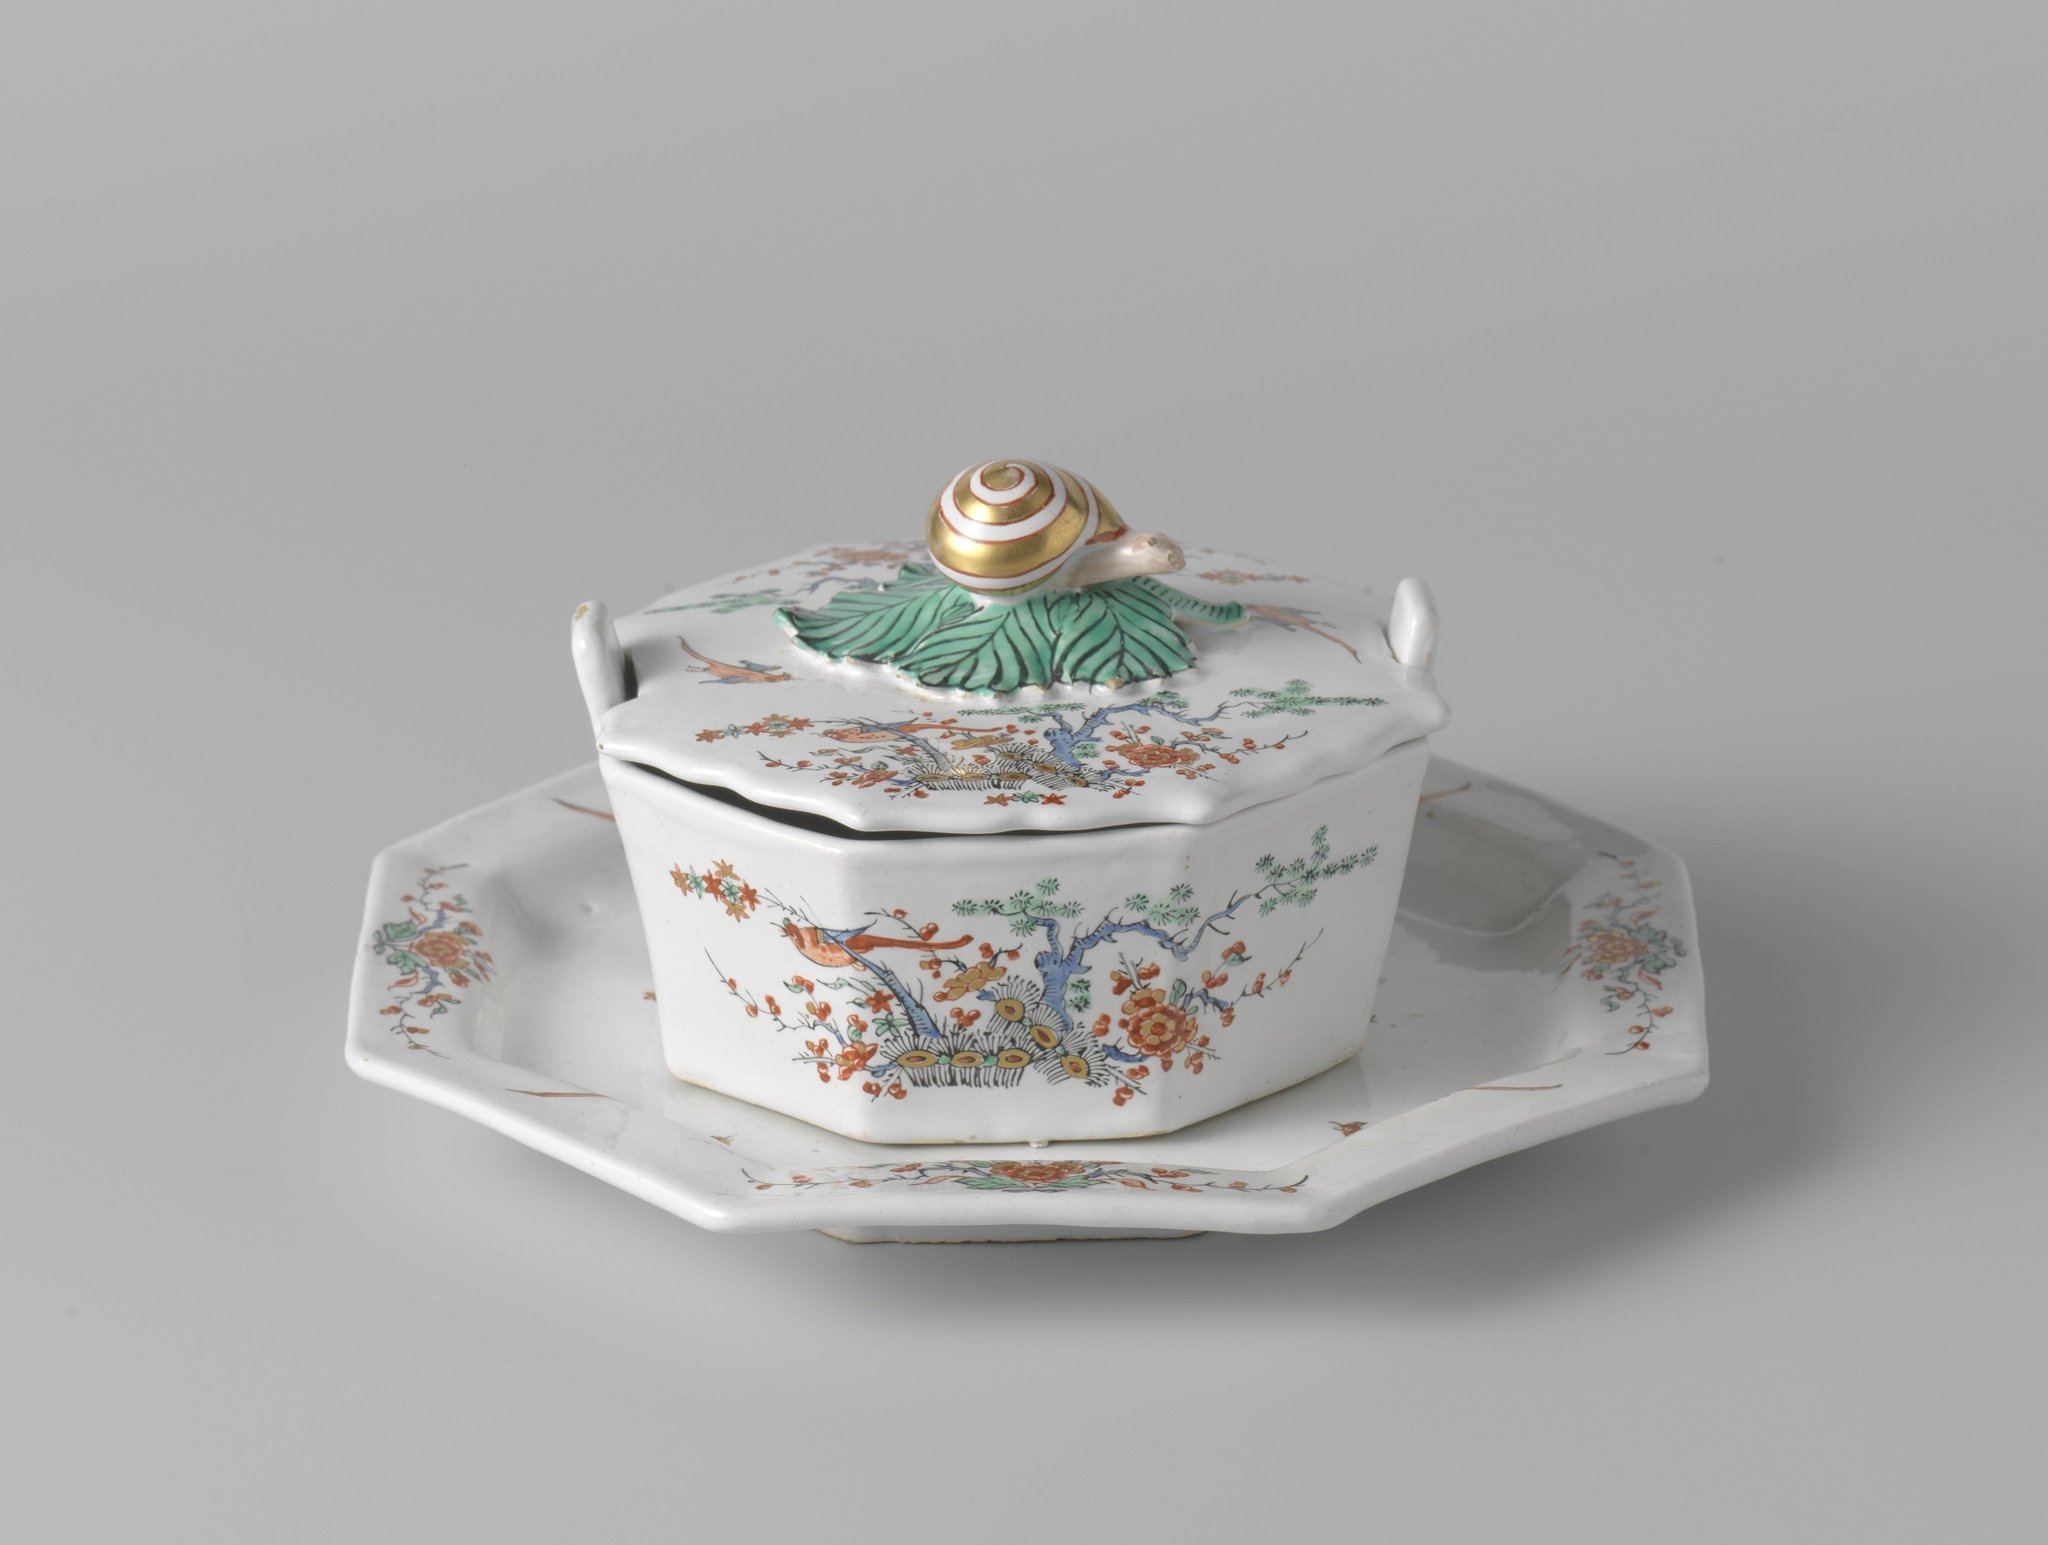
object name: platter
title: Onderschotel voor botervloot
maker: Anonymous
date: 1740-1760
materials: earthenware, glaze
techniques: painted, polychromy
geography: delft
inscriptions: mark: ‘1’, mark: ‘80’, mark: ‘2’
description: Onderschotel voor botervloot van veelkleurig beschilderde faience, met kakiemon-decor. Alle delen zijn beschilderd in de moffelkleuren blauw, rood, groen, zwart en goud met twee gebonden heggen, bloeiende bomen, een vogel op een tak en losse vogels.